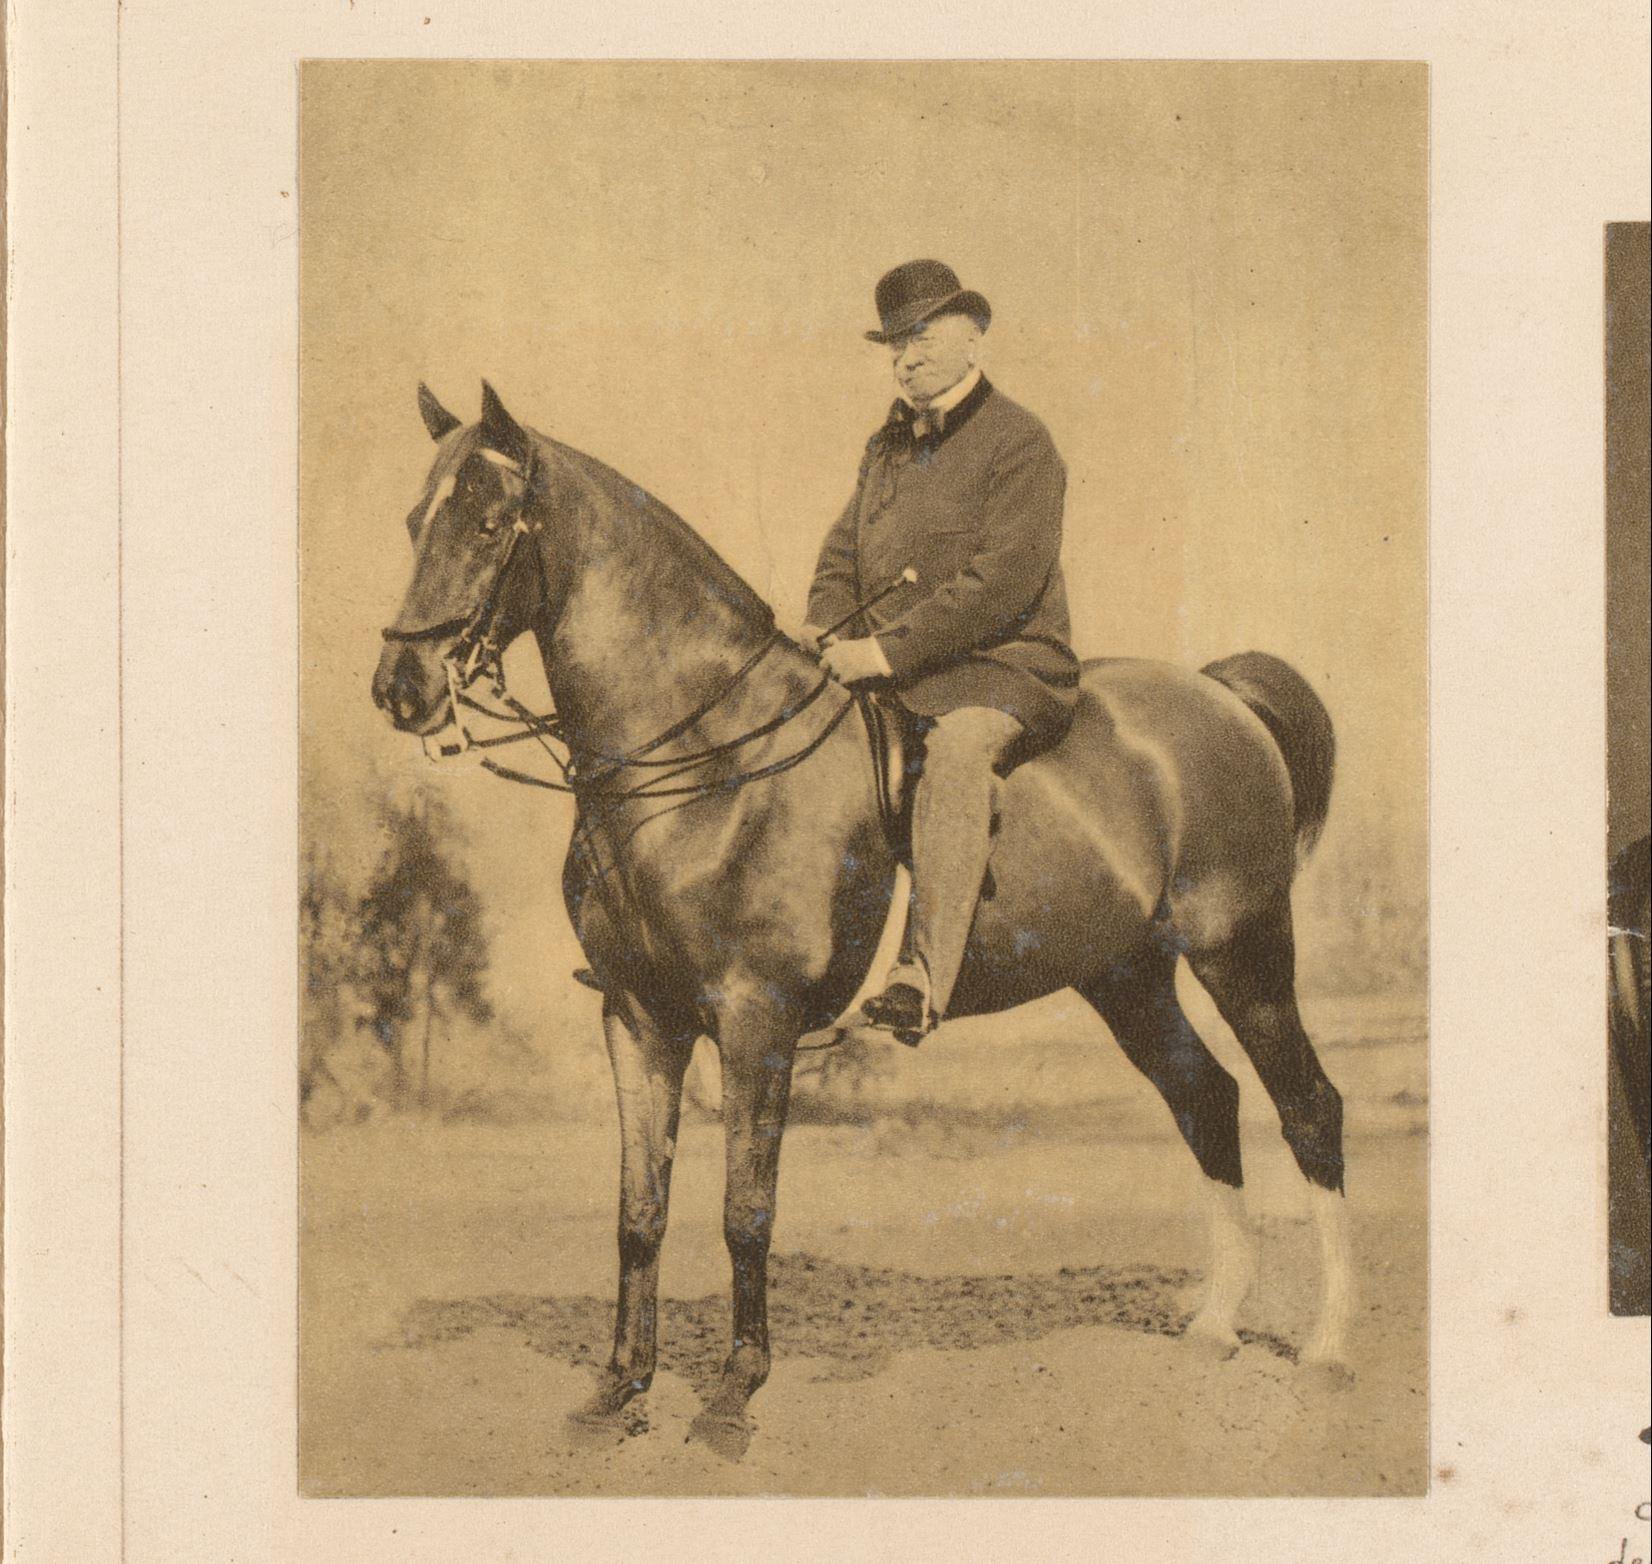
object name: photograph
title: Emile de Girardin (en 1866)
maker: Anonymous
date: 1866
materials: paper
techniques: rotogravure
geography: france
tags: paris, publisher, émile de girardin, writer, poet, author, france